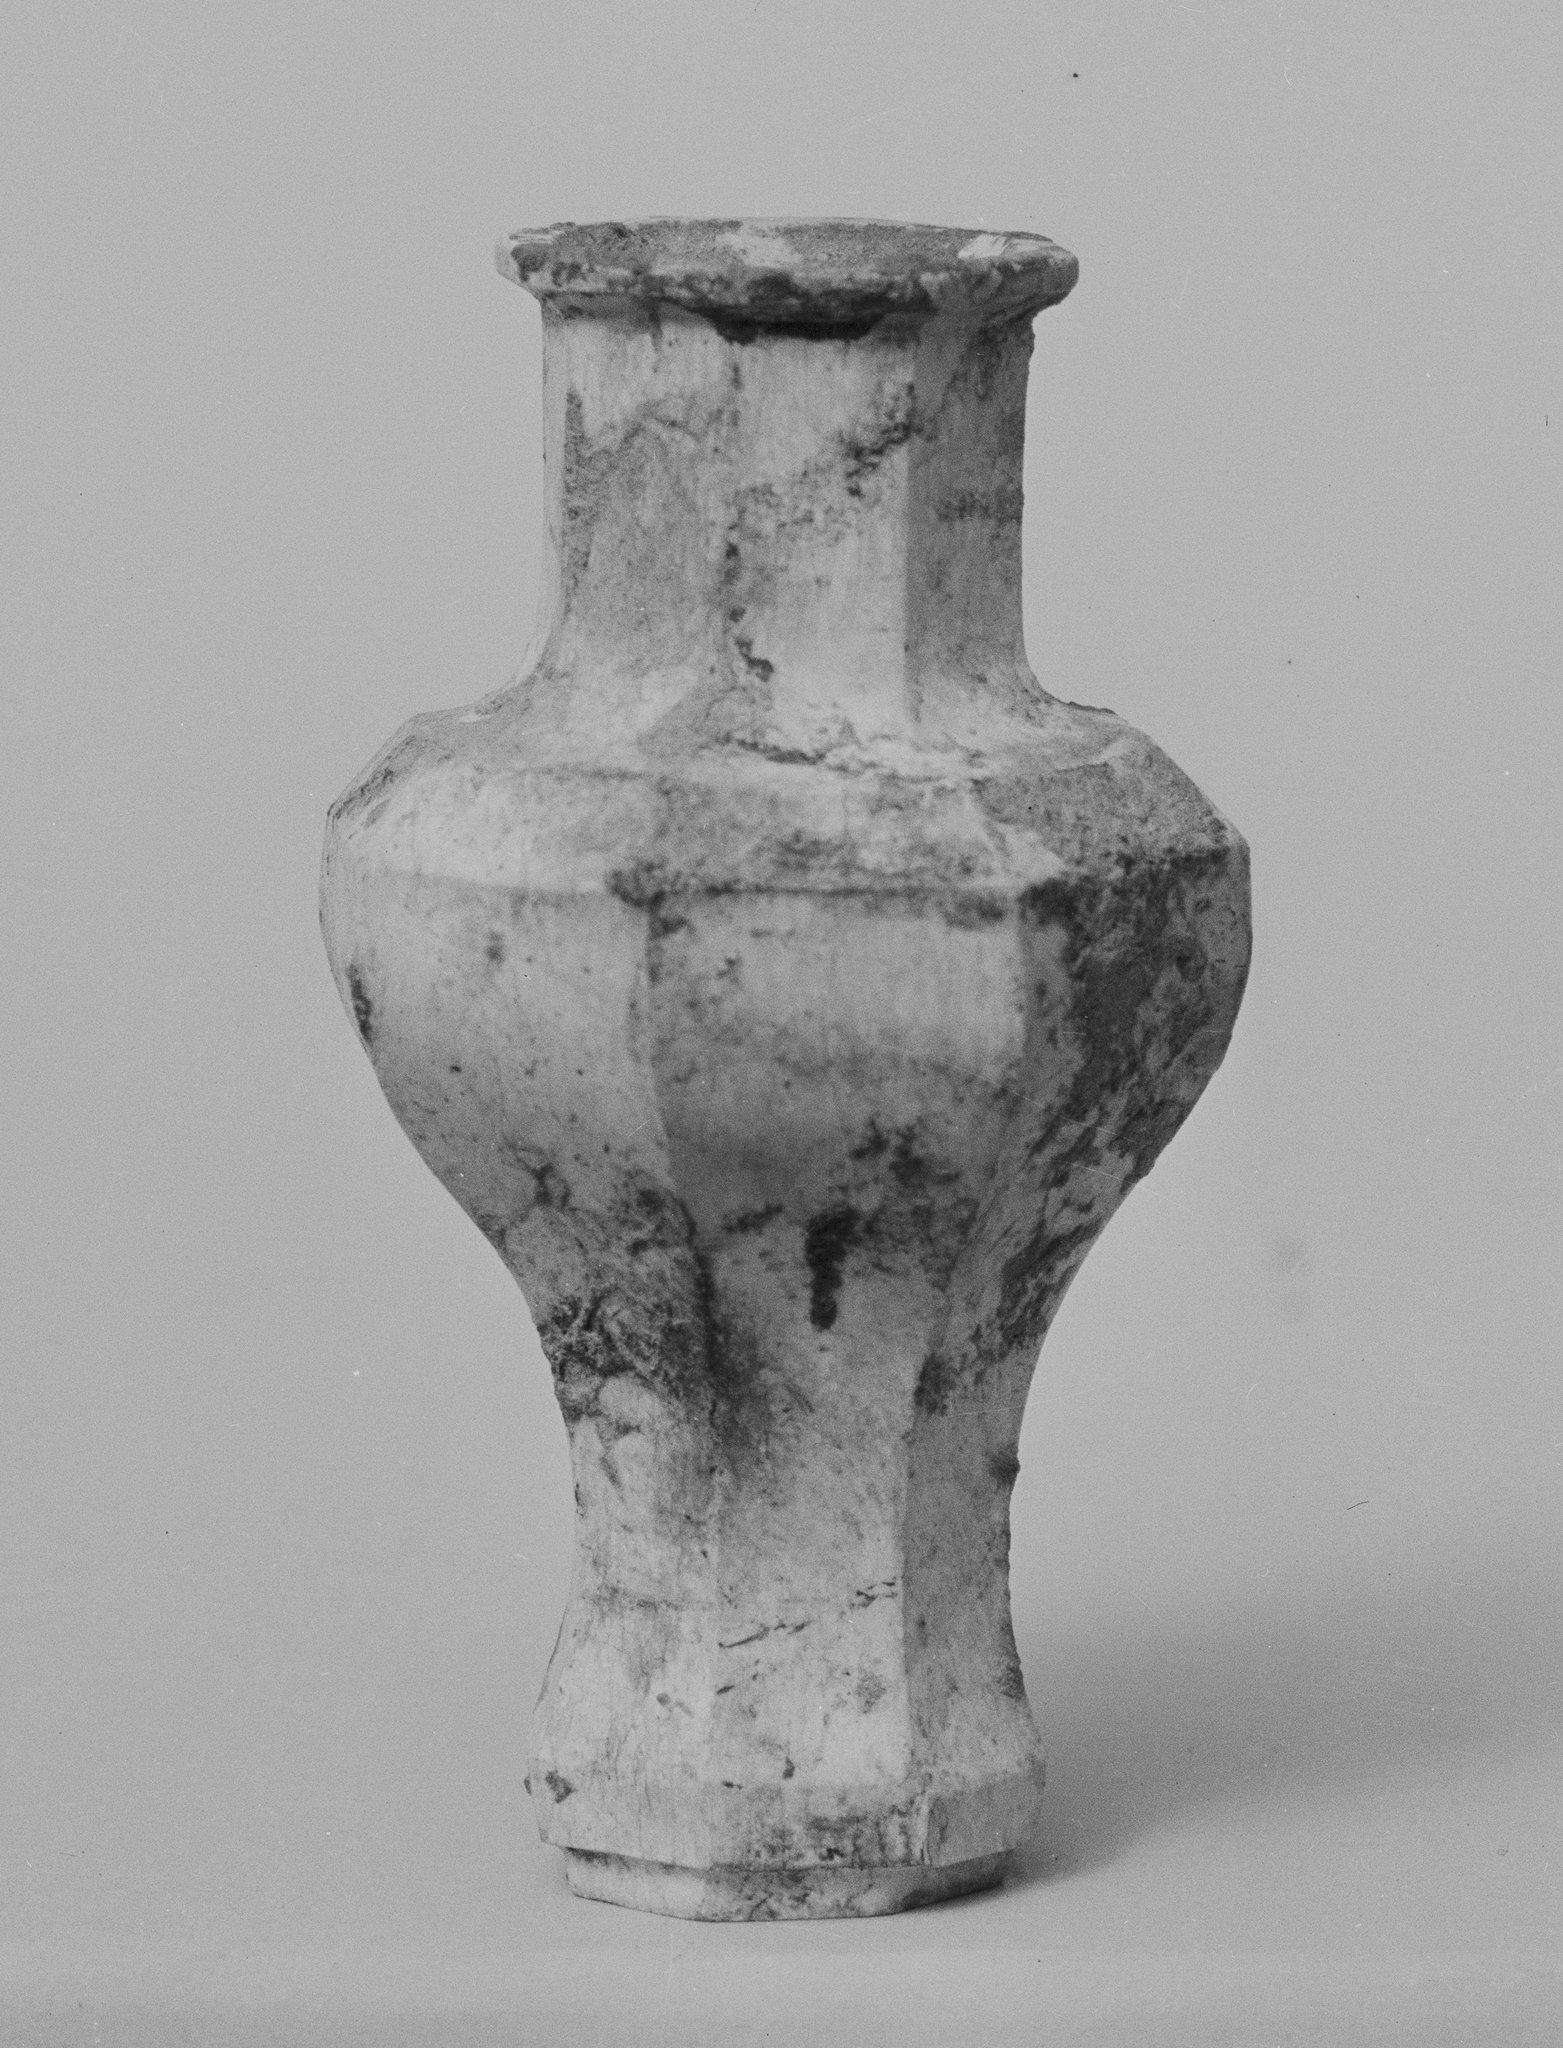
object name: vase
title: Octagonal Vase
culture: chinese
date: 618-907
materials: jade